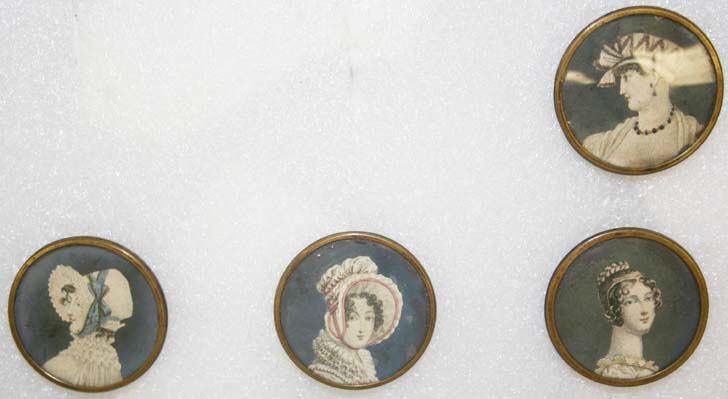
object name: button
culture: french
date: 1790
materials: glass, metal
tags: portraits,women